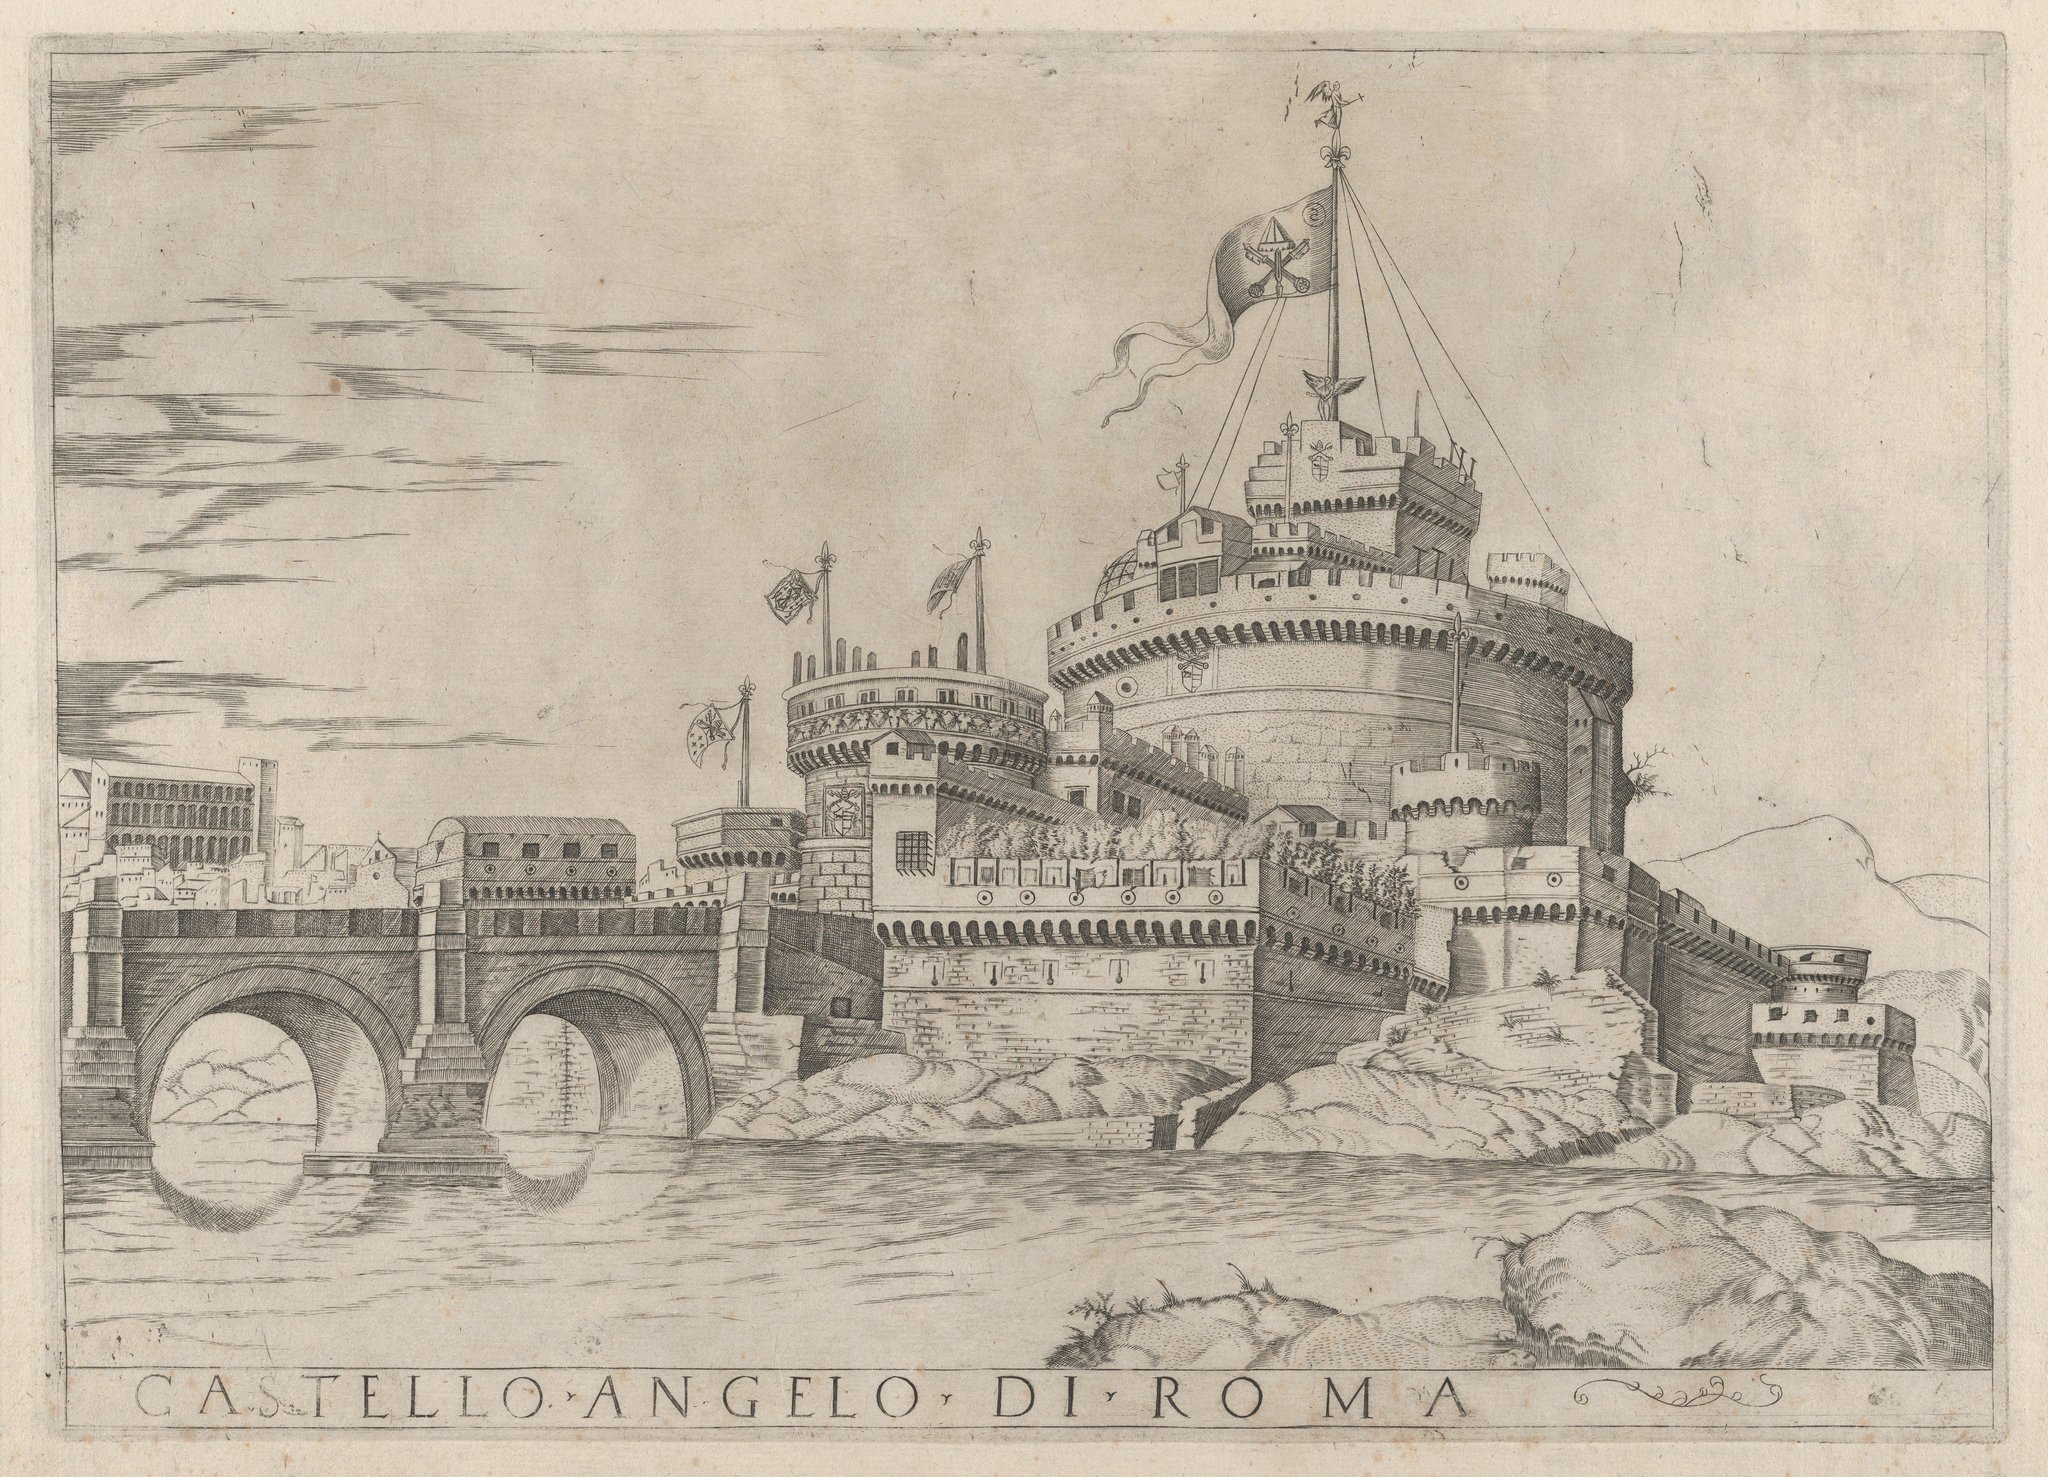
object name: print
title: Castello Sant' Angelo, from "Speculum Romanae Magnificentiae"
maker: Anonymous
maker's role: artist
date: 1501-1600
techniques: engraving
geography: rome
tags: castles,rome